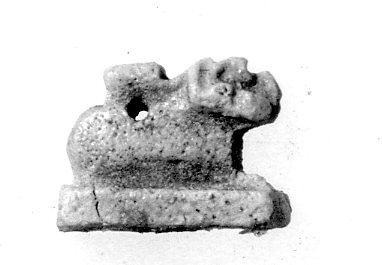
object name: amulet, recumbent ram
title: Ram amulet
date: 664-332 BCE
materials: faience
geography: egypt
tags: rams